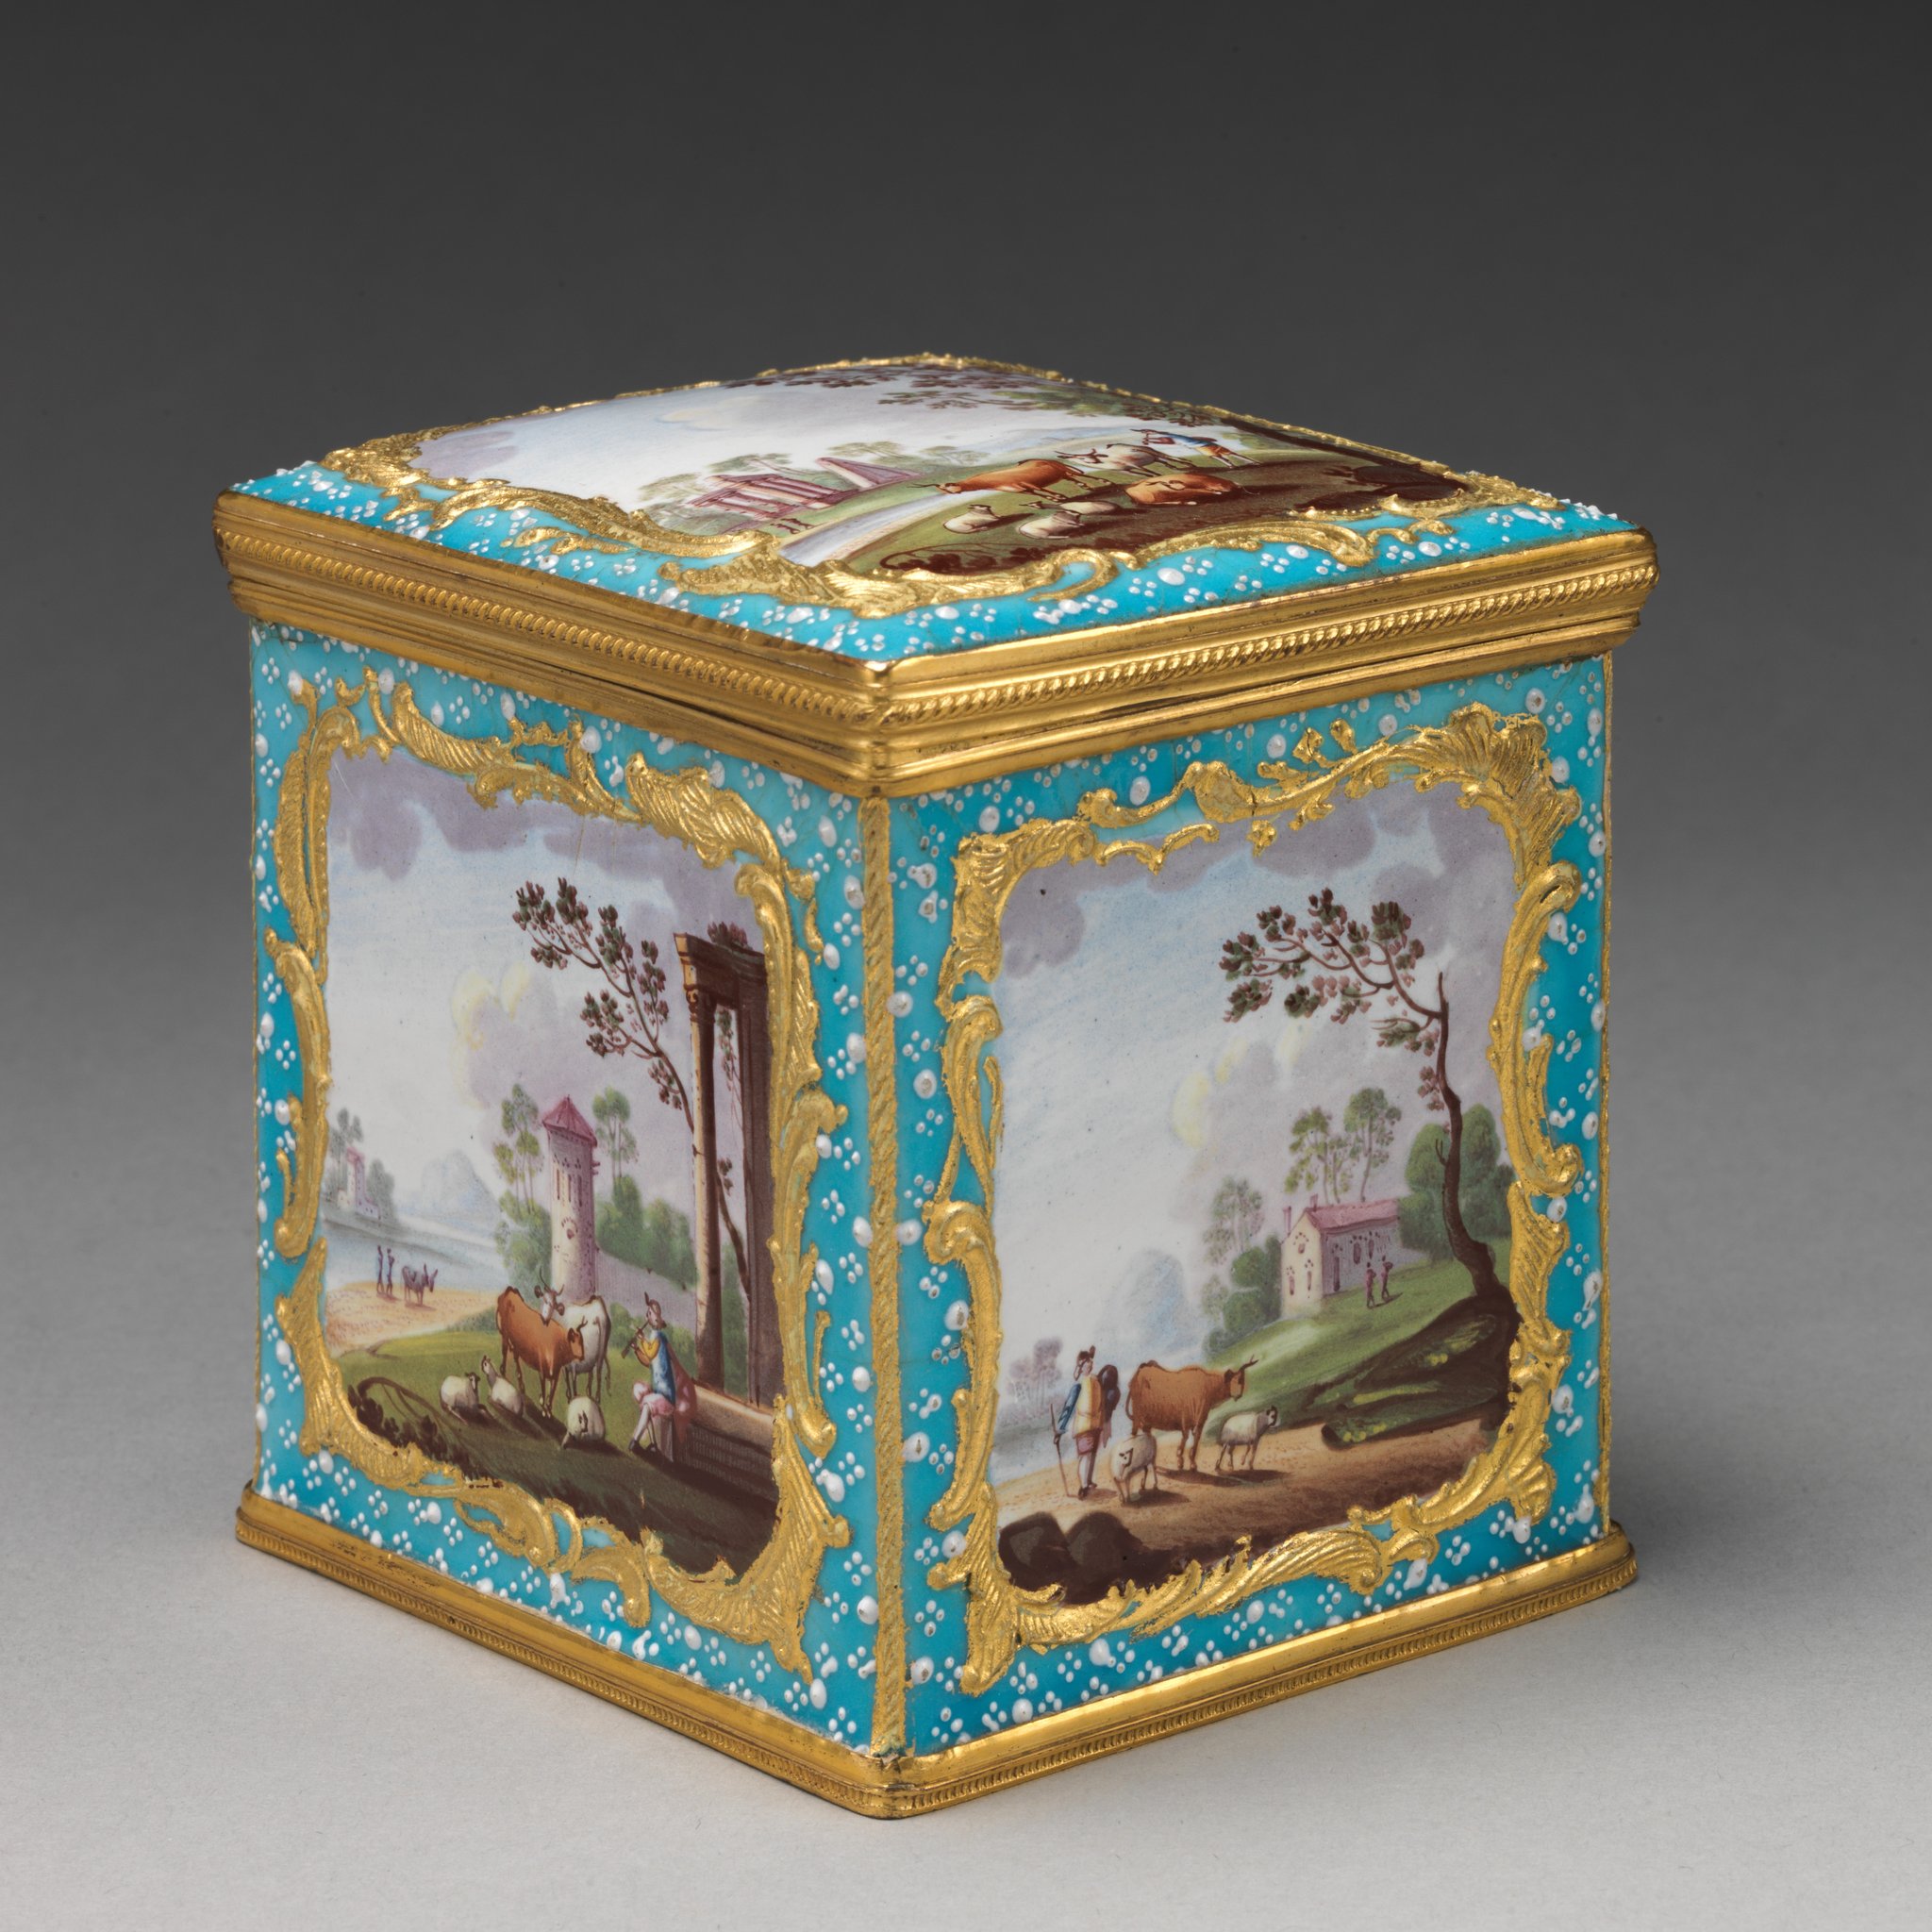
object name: sugar canister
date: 1765-1770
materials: copper, enamel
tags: animals,houses,men,trees